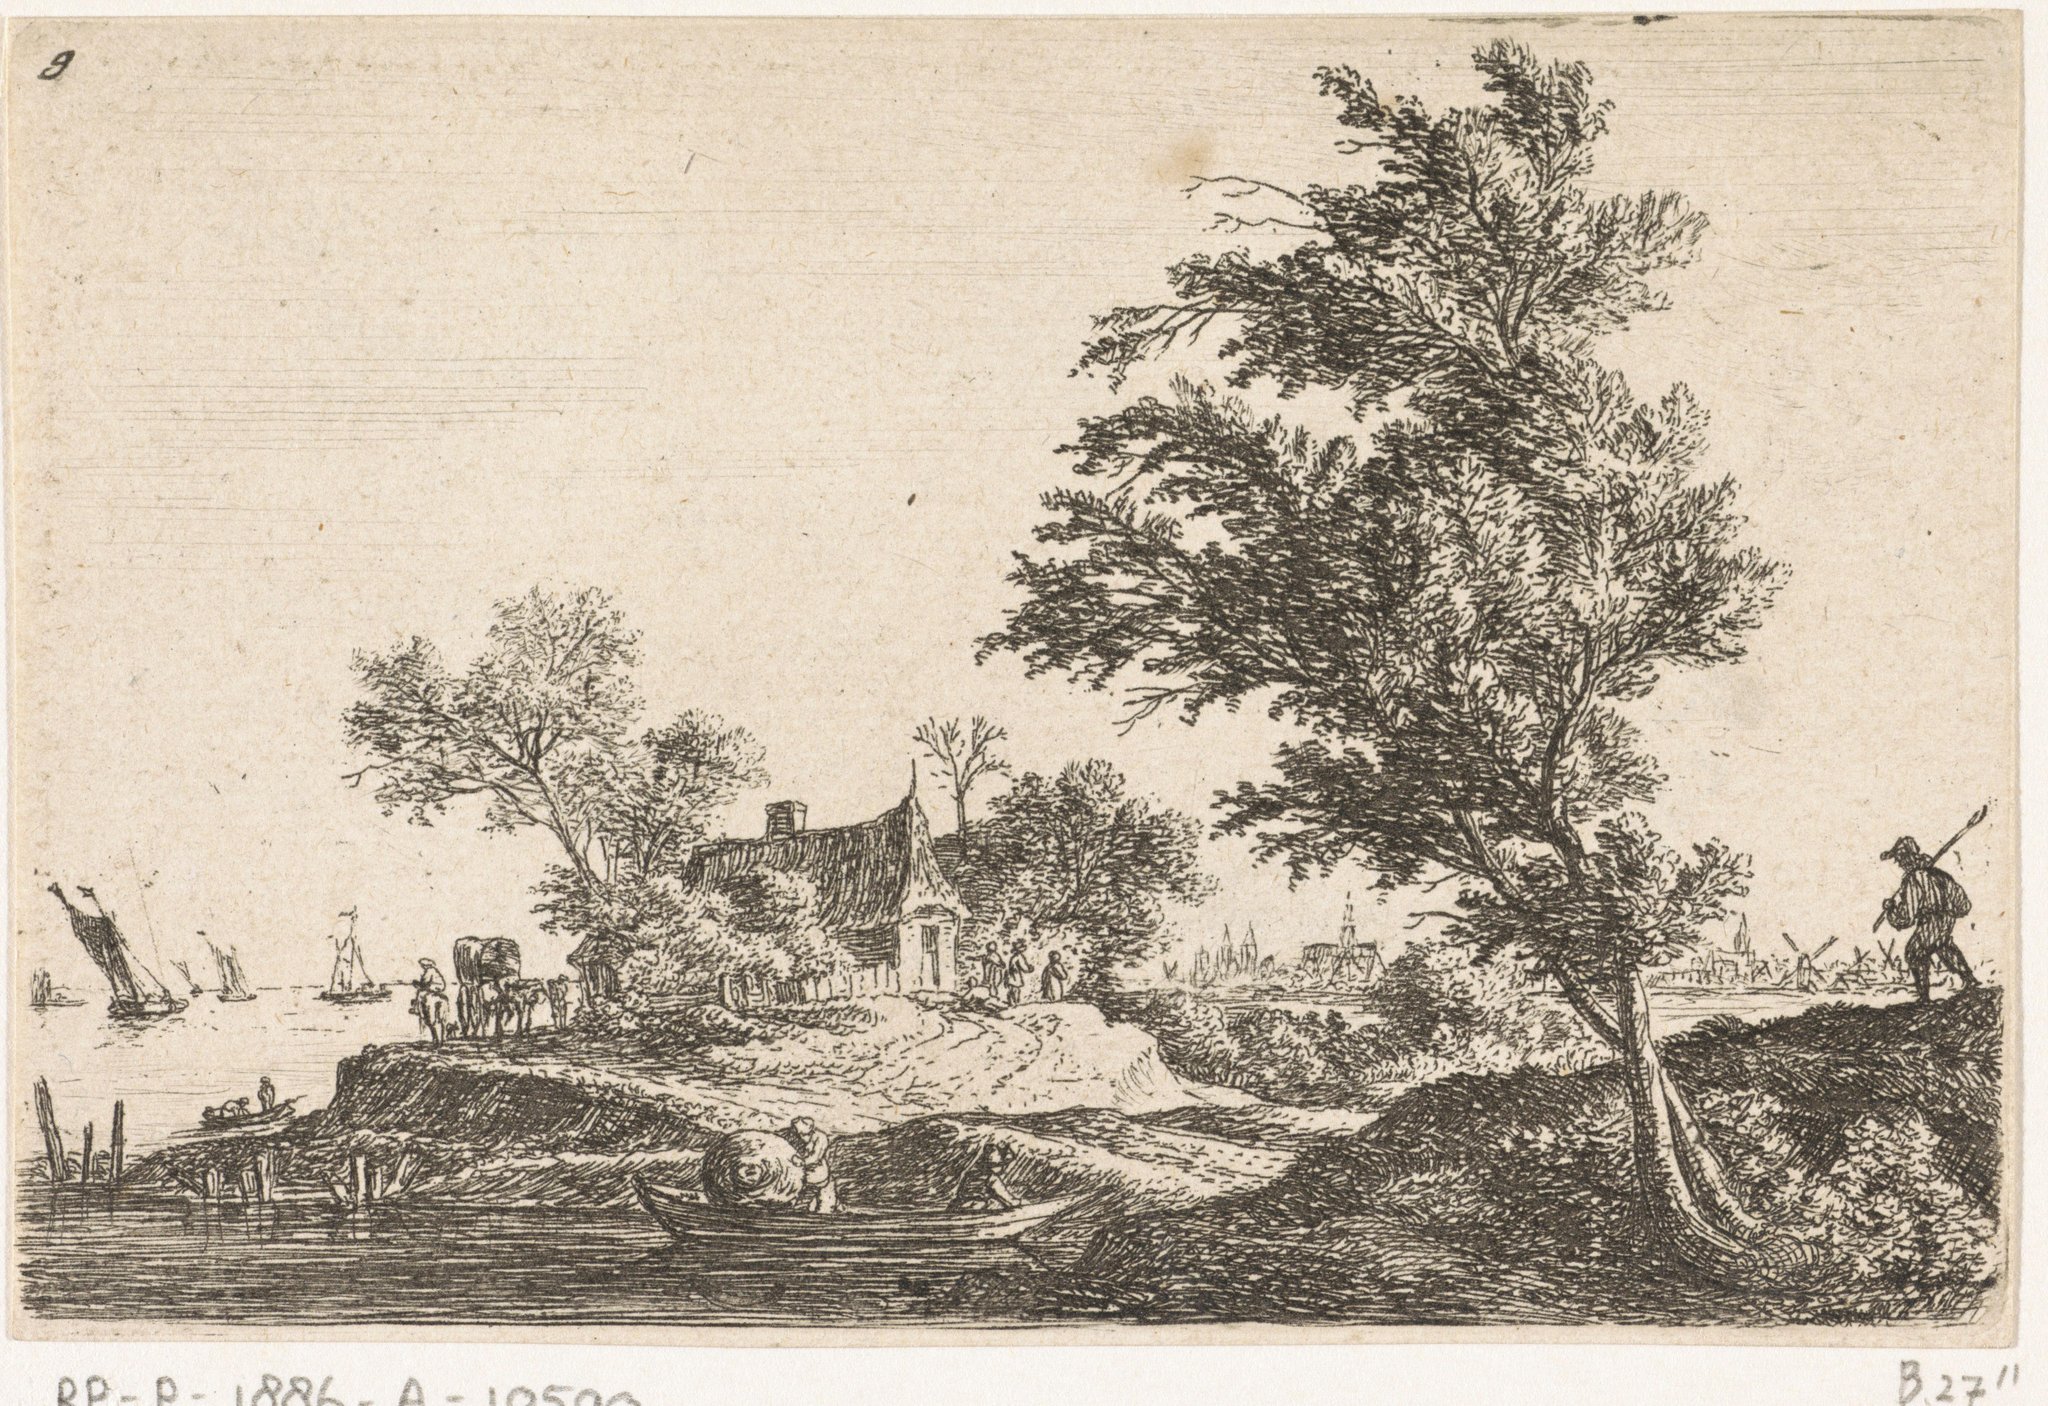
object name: print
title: Landschappen met figuren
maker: anthonie waterloo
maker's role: draughtsman, painter, print maker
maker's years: 1609-1690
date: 1630-1663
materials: paper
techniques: etching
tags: city-view, and landscape with man-made constructions, sailing-ship, sailing-boat, landscapes with waters, waterscapes, seascapes (in the temperate zone), rural housing, e.g. country-house, villa, cottage, rowing-boat, canoe, etc., 'en route', traveller under way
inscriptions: collector's mark: Lugt 2228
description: Aan het water ligt een huis. In het water liggen boten. Rechts in de verte ligt een stad en vooraan rechts loopt een reiziger. Linksboven is de letter g te zien.